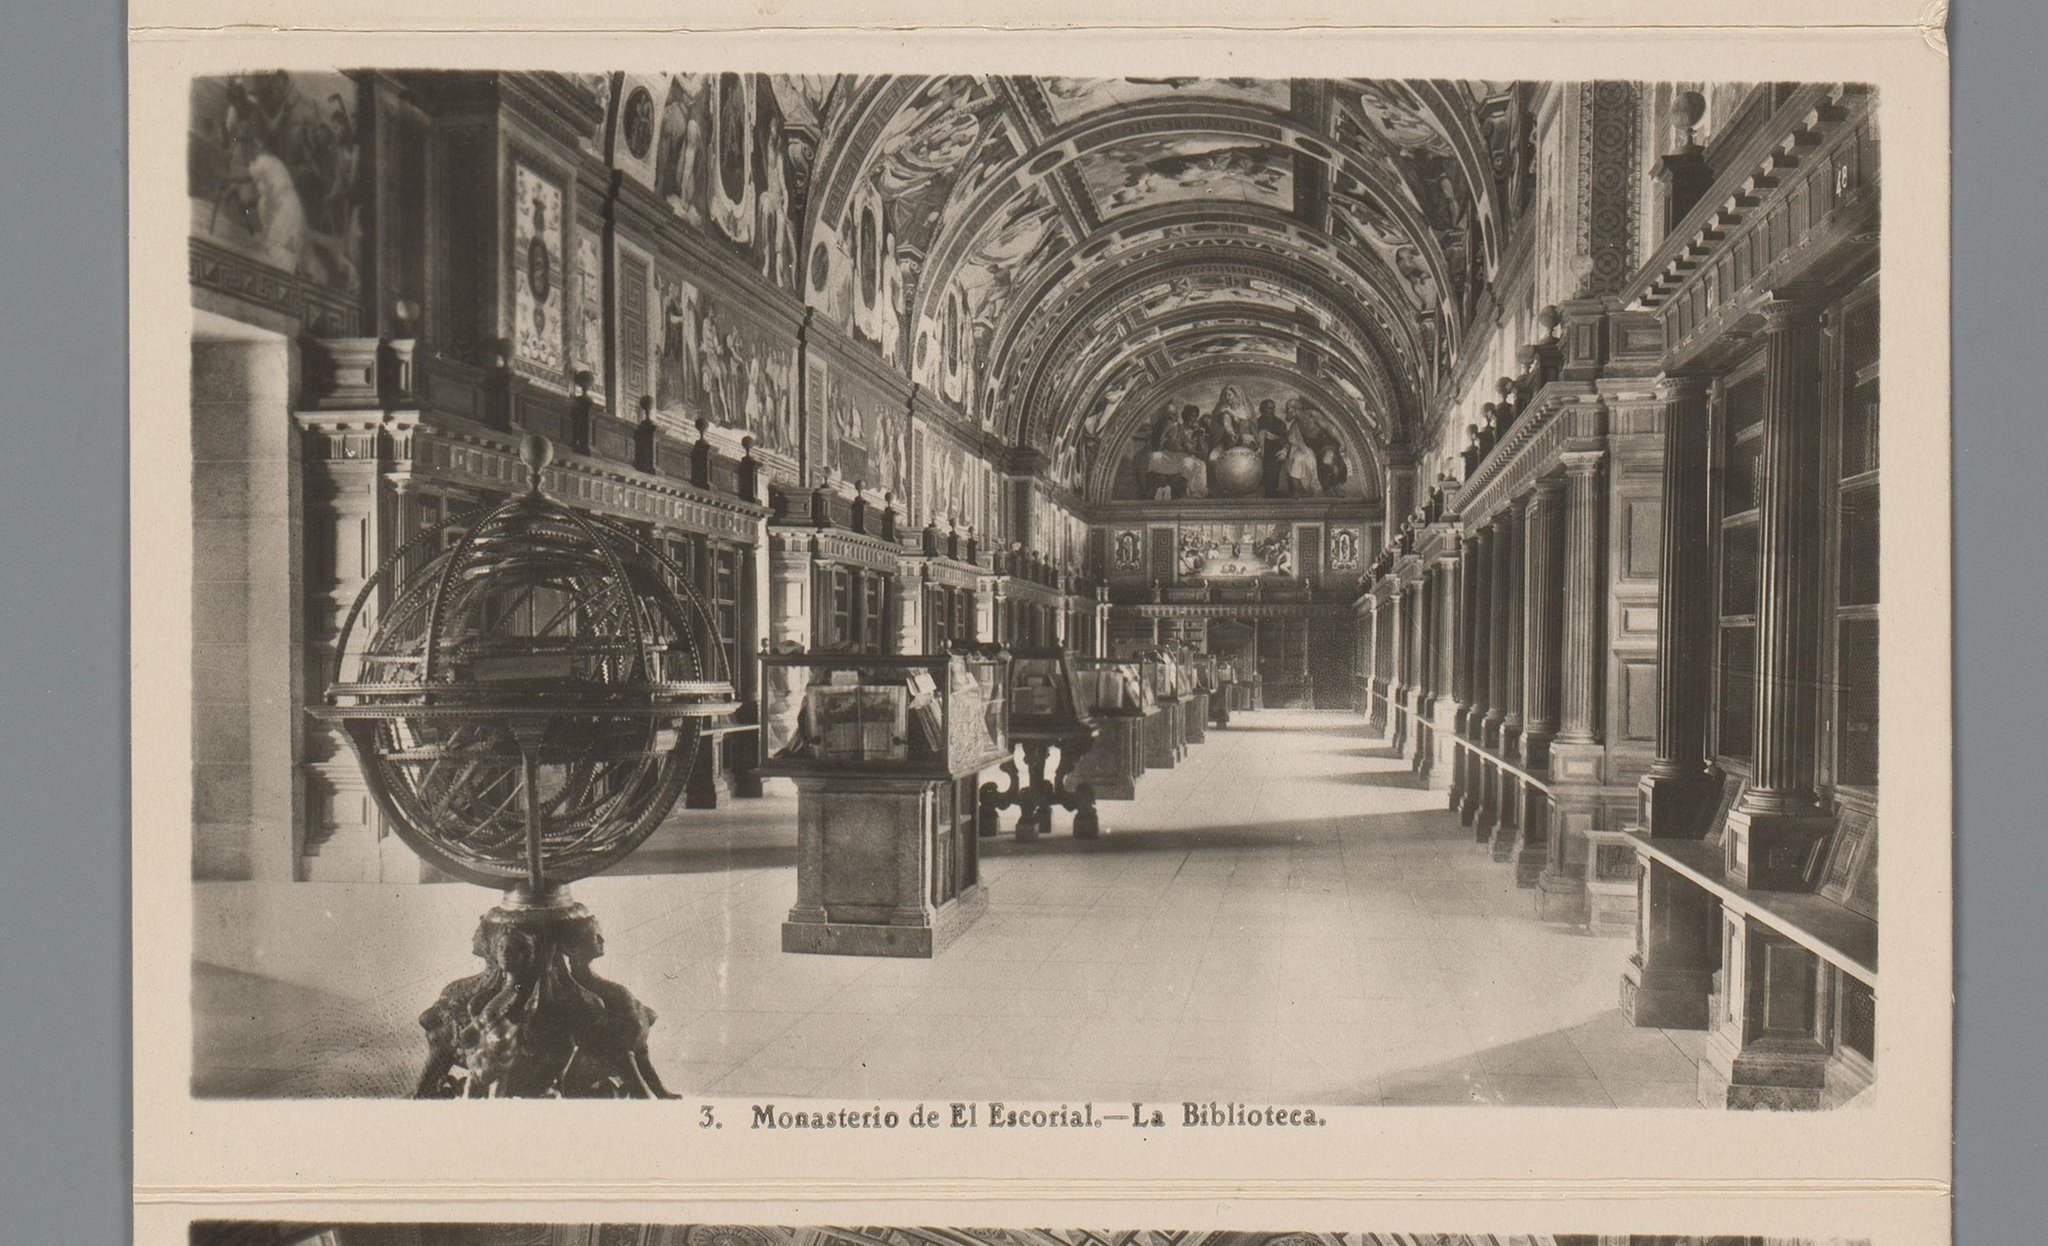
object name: ansichtkaart, prentbriefkaart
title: Monasterio de El Escorial - La Biblioteca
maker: Anonymous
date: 1918-1930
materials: paper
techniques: gelatin silver print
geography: san lorenzo de el escorial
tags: abbey, monastery, convent ~ roman catholic church, study; 'studiolo'; library